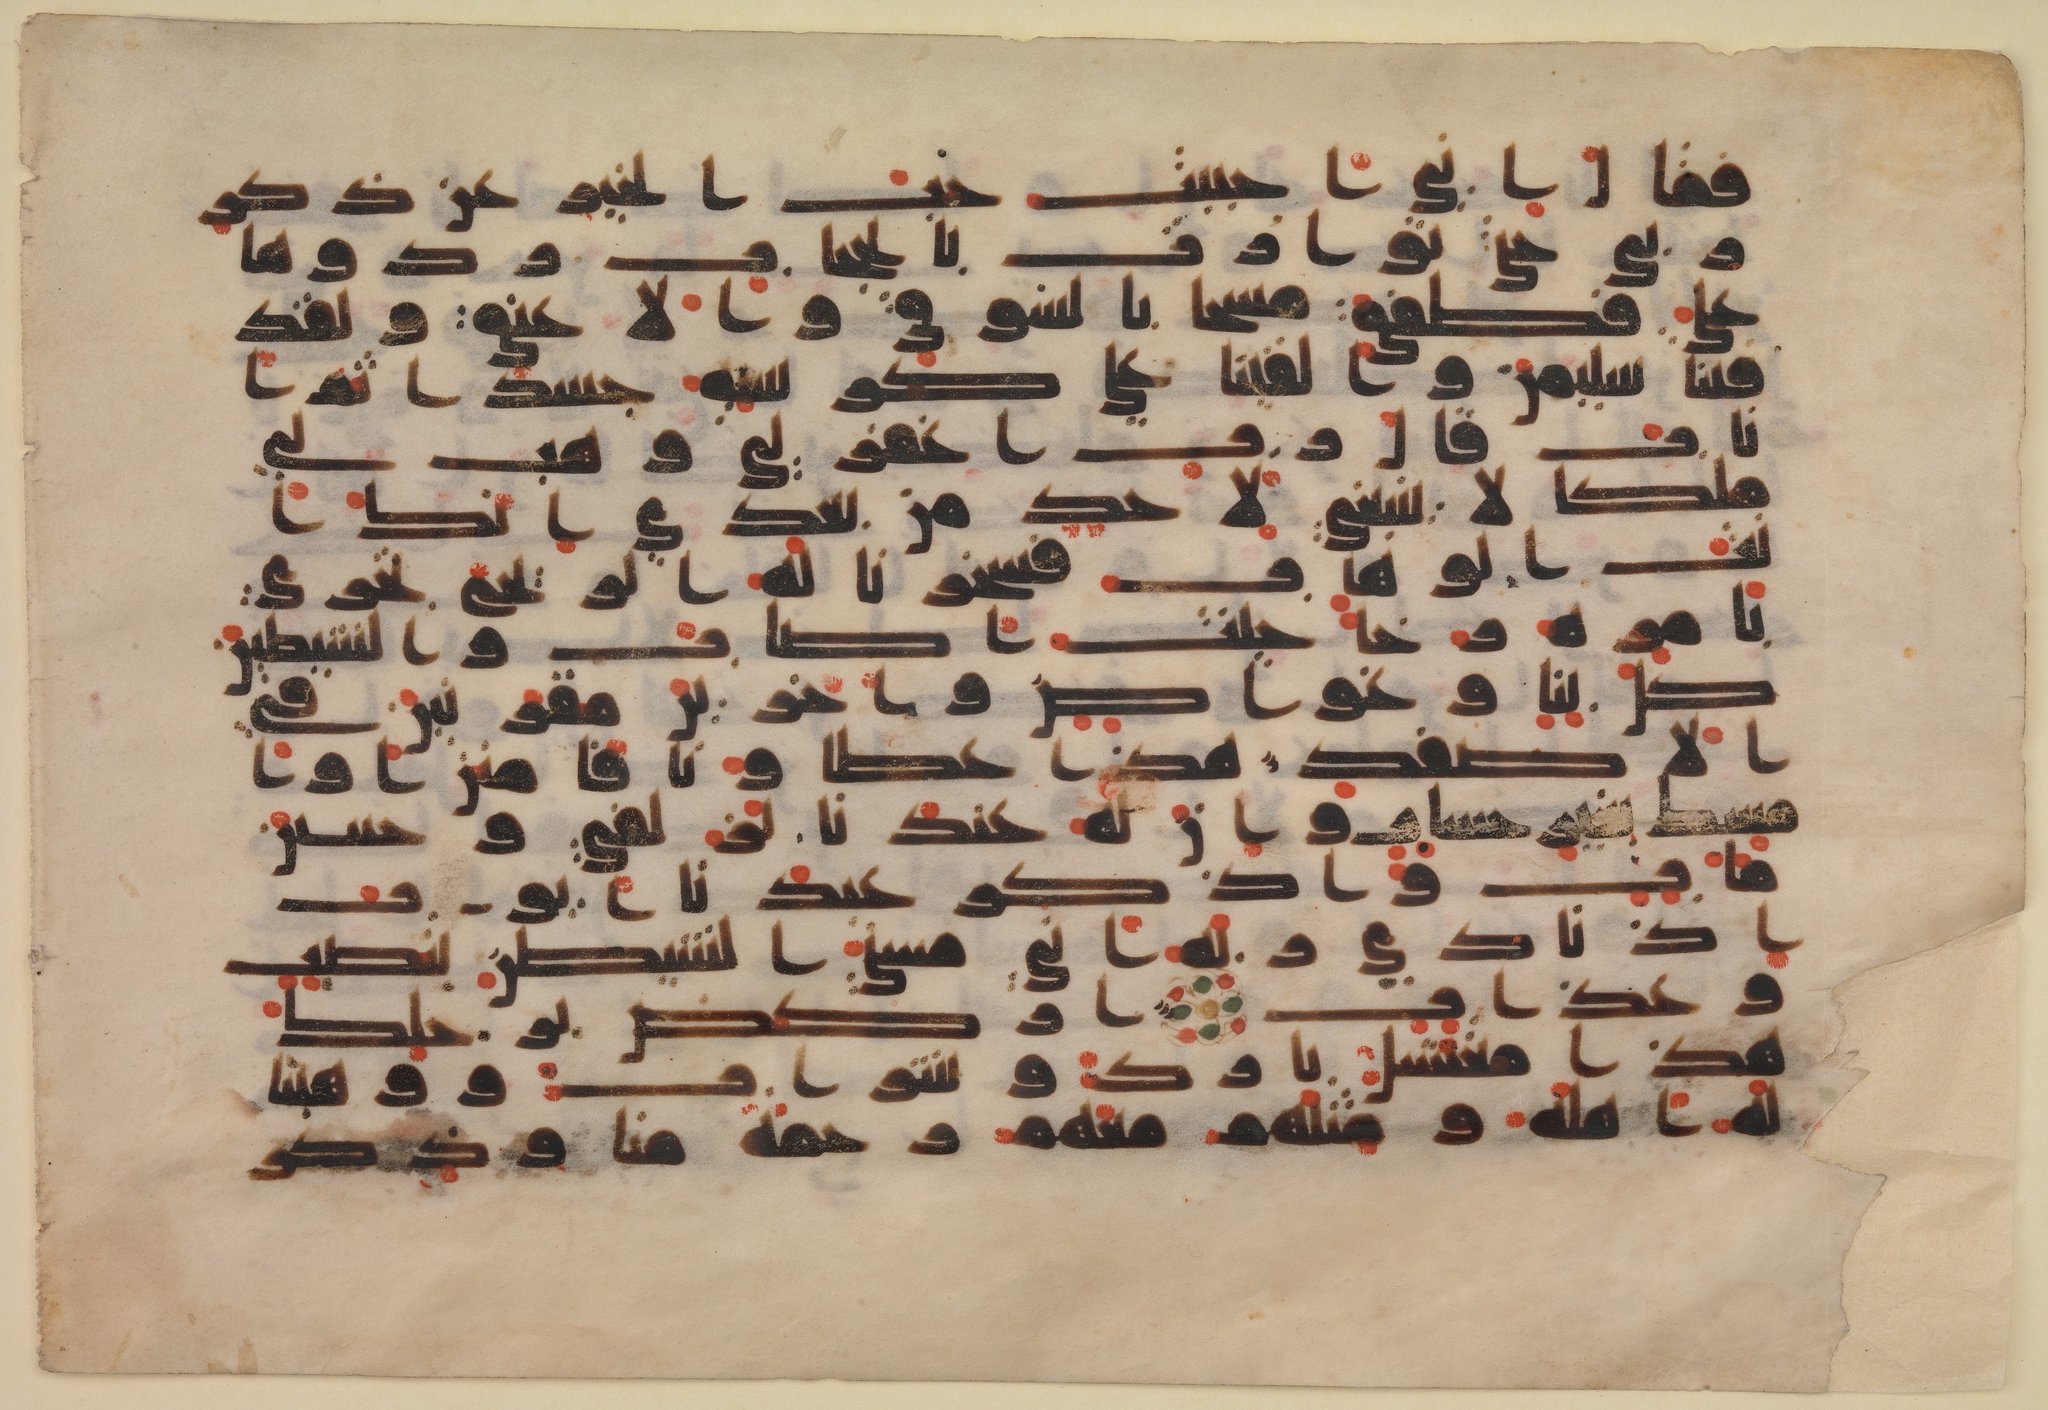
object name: folio from a non illustrated manuscript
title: Folio from a Qur'an Manuscript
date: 701-900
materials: ink, parchment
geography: egypt or iraq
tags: qur'an,calligraphy